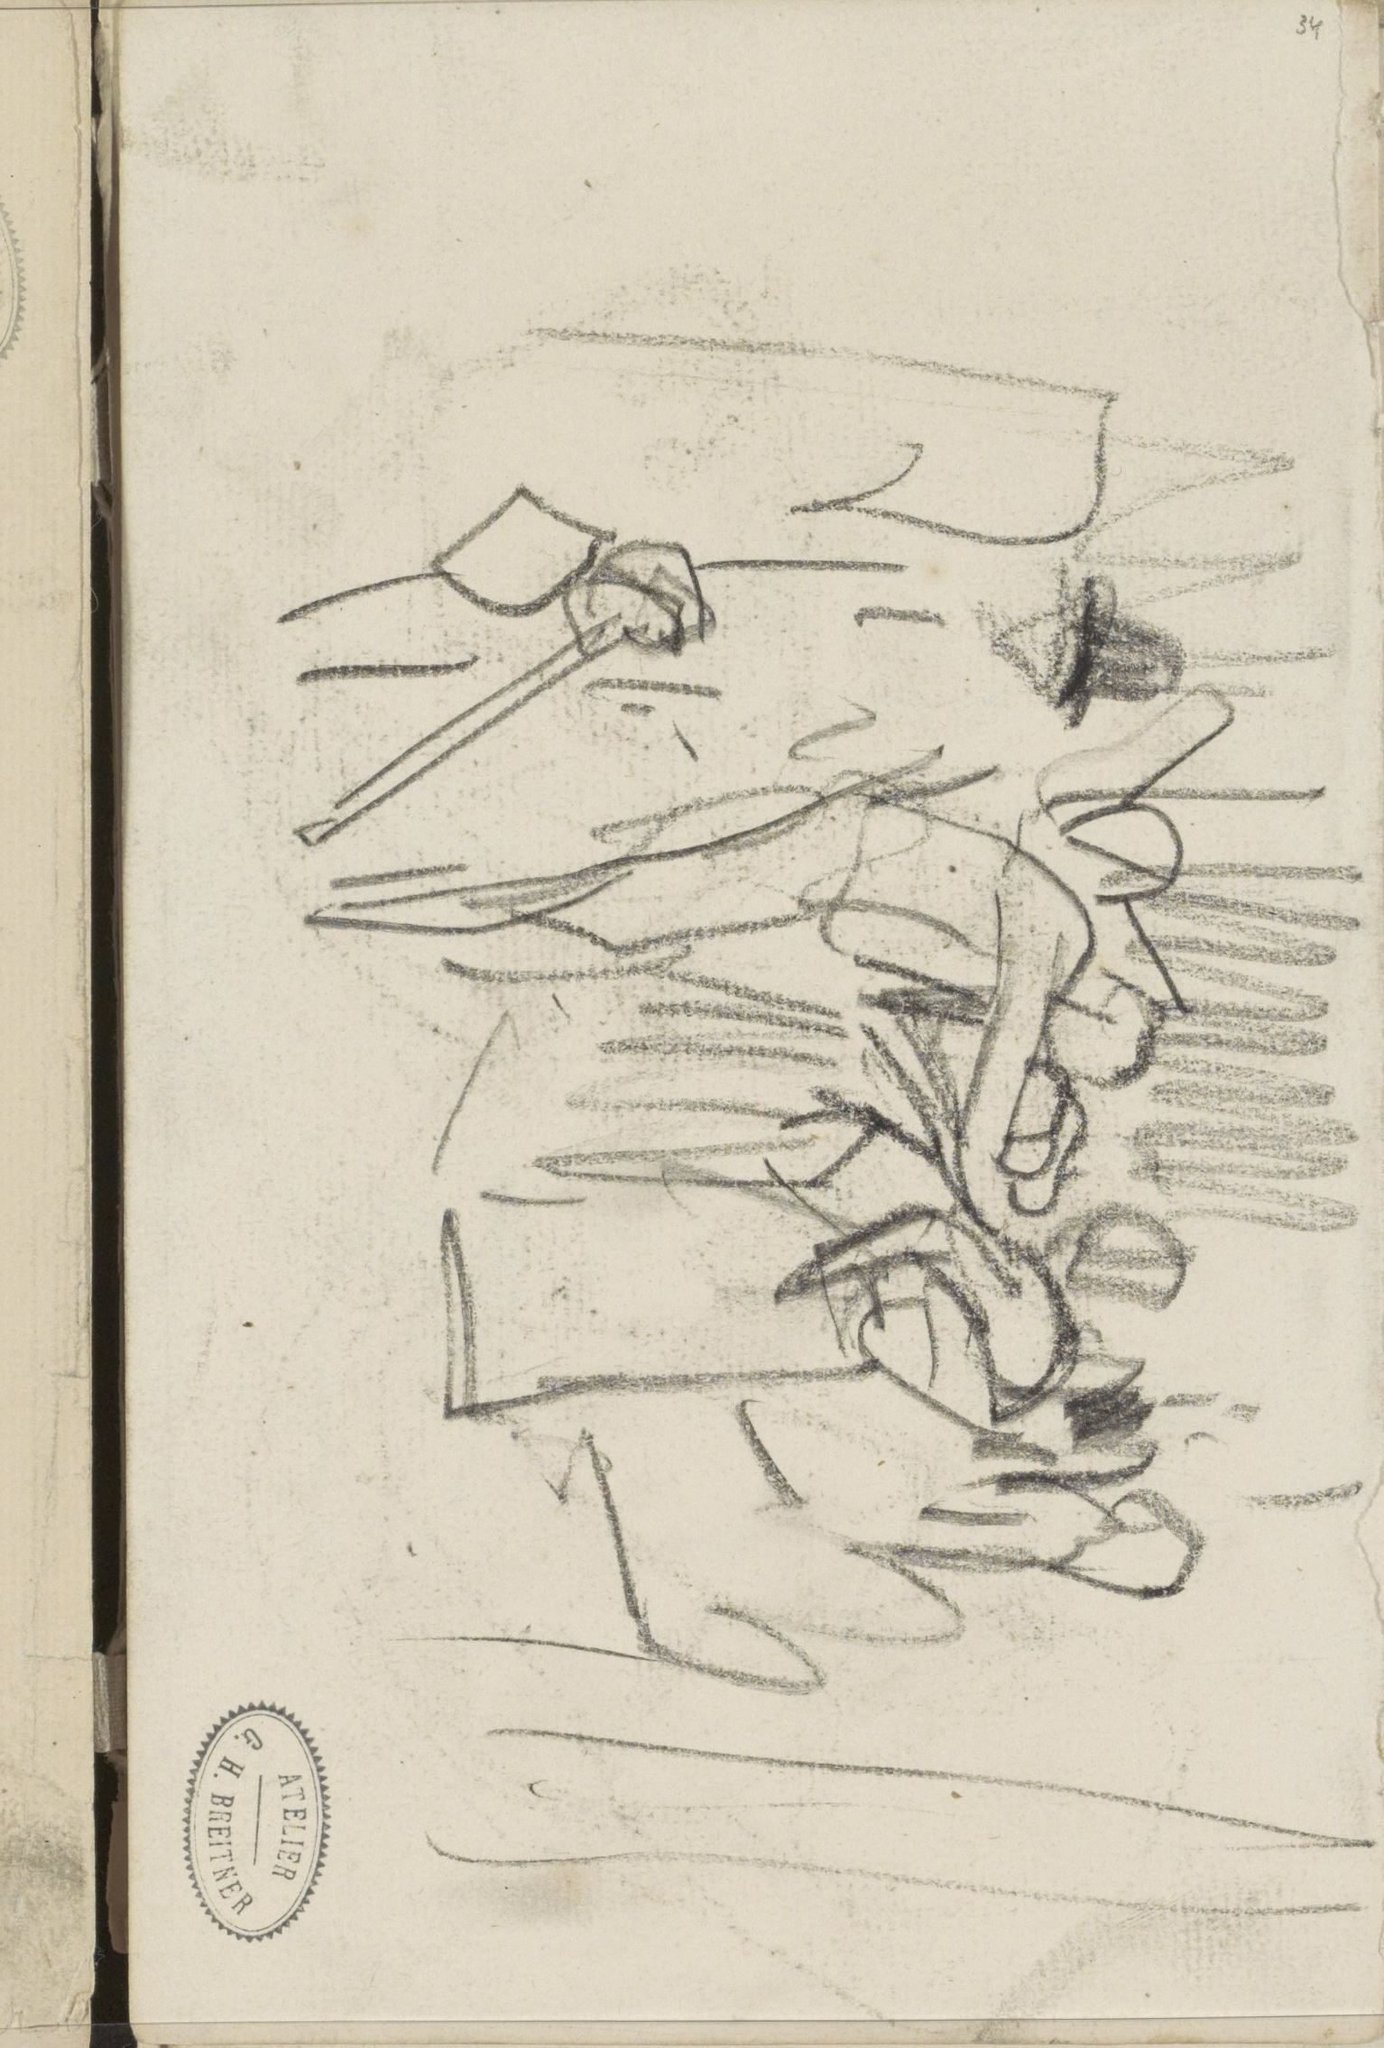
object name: sketchbook leaf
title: Groep figuren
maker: george hendrik breitner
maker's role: draughtsman, painter, print maker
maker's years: 1857-1923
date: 1886-1923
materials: chalk, paper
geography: amsterdam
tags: adult woman, adult man, child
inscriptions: workshop stamp: Lugt 291d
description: Pagina 34 uit een schetsboek met 19 bladen en 9 losse tekeningen.